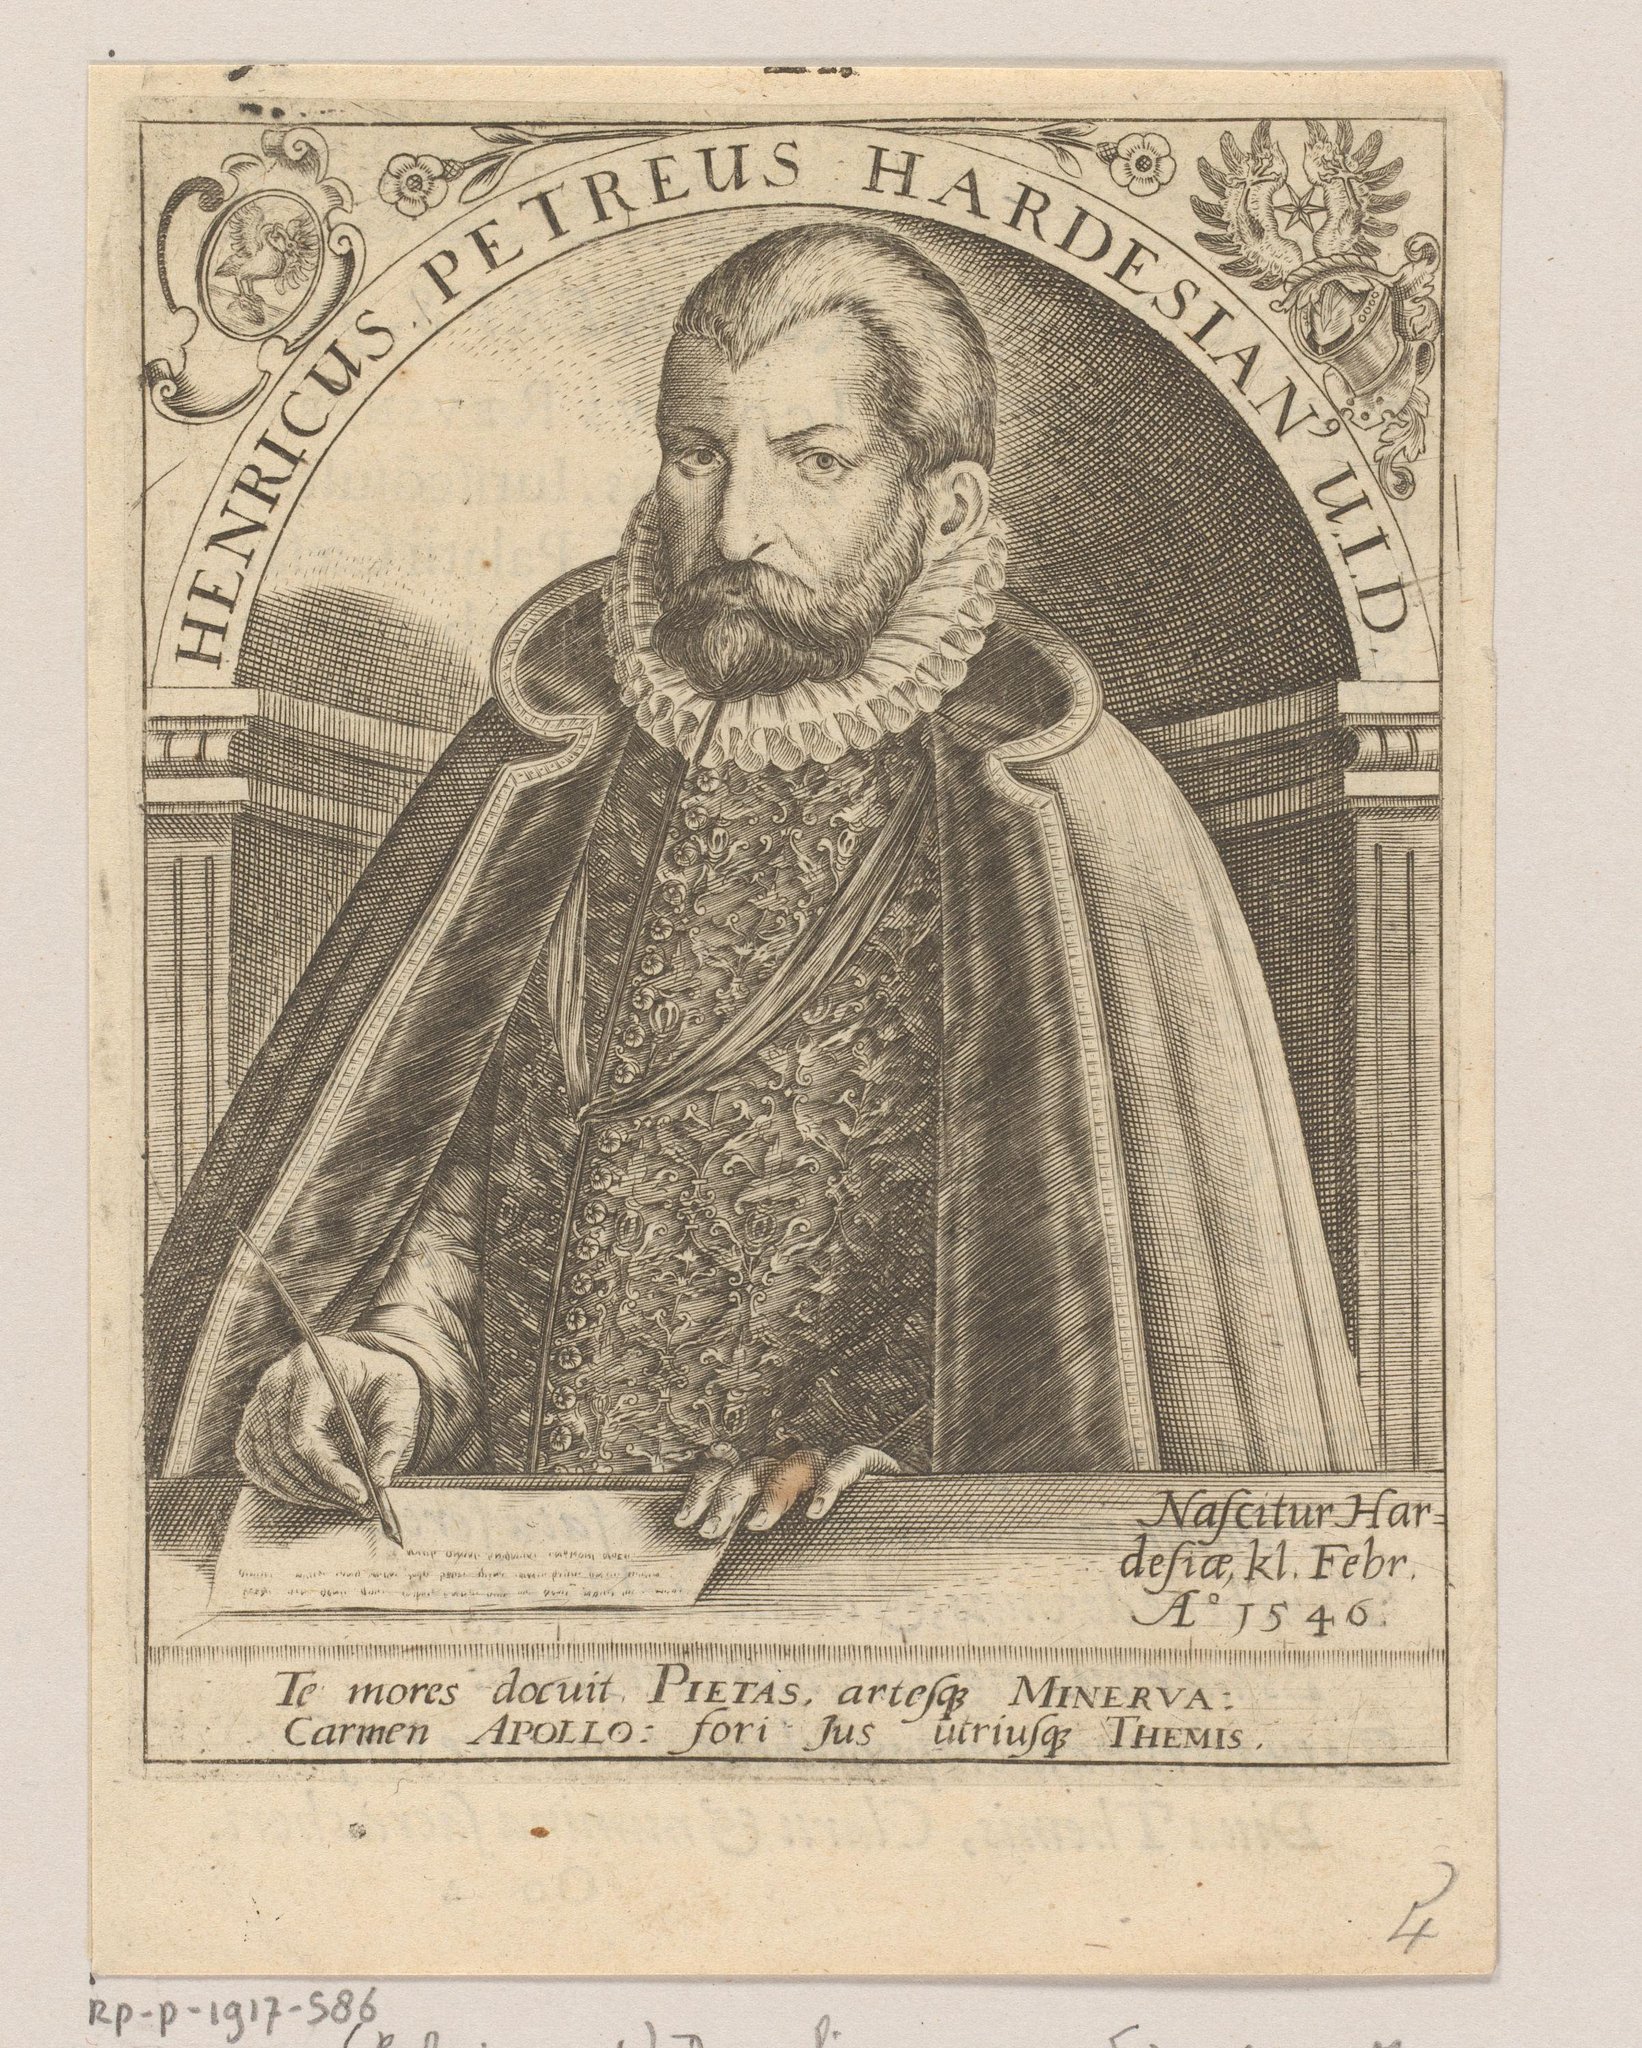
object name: print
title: Henricus. Petreus Hardesian[9] U.I.D.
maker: jean jacques boissard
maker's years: 1528-1598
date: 1597-1599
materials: paper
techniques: engraving, letterpress printing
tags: historical persons, portrait of a writer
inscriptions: collector's mark: Lugt 2228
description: Prent mogelijk gebruikt in: Boissard, Jean Jacques. Icones quinquaginta virorum illustrium doctrina & eruditione praestantium ad vivum effictae. 4 dln. Frankfurt am Main: s.n., 1597-1599. Deze prent komt waarschijnlijk uit een latere editie. Latere staat van prent verschenen in: Boissard, Jean Jacques. Bibliotheca chalcographica. 8 dln. Frankfurt am Main: Johannes Ammon, 1650-1652. Ook gebruikt in latere edities.